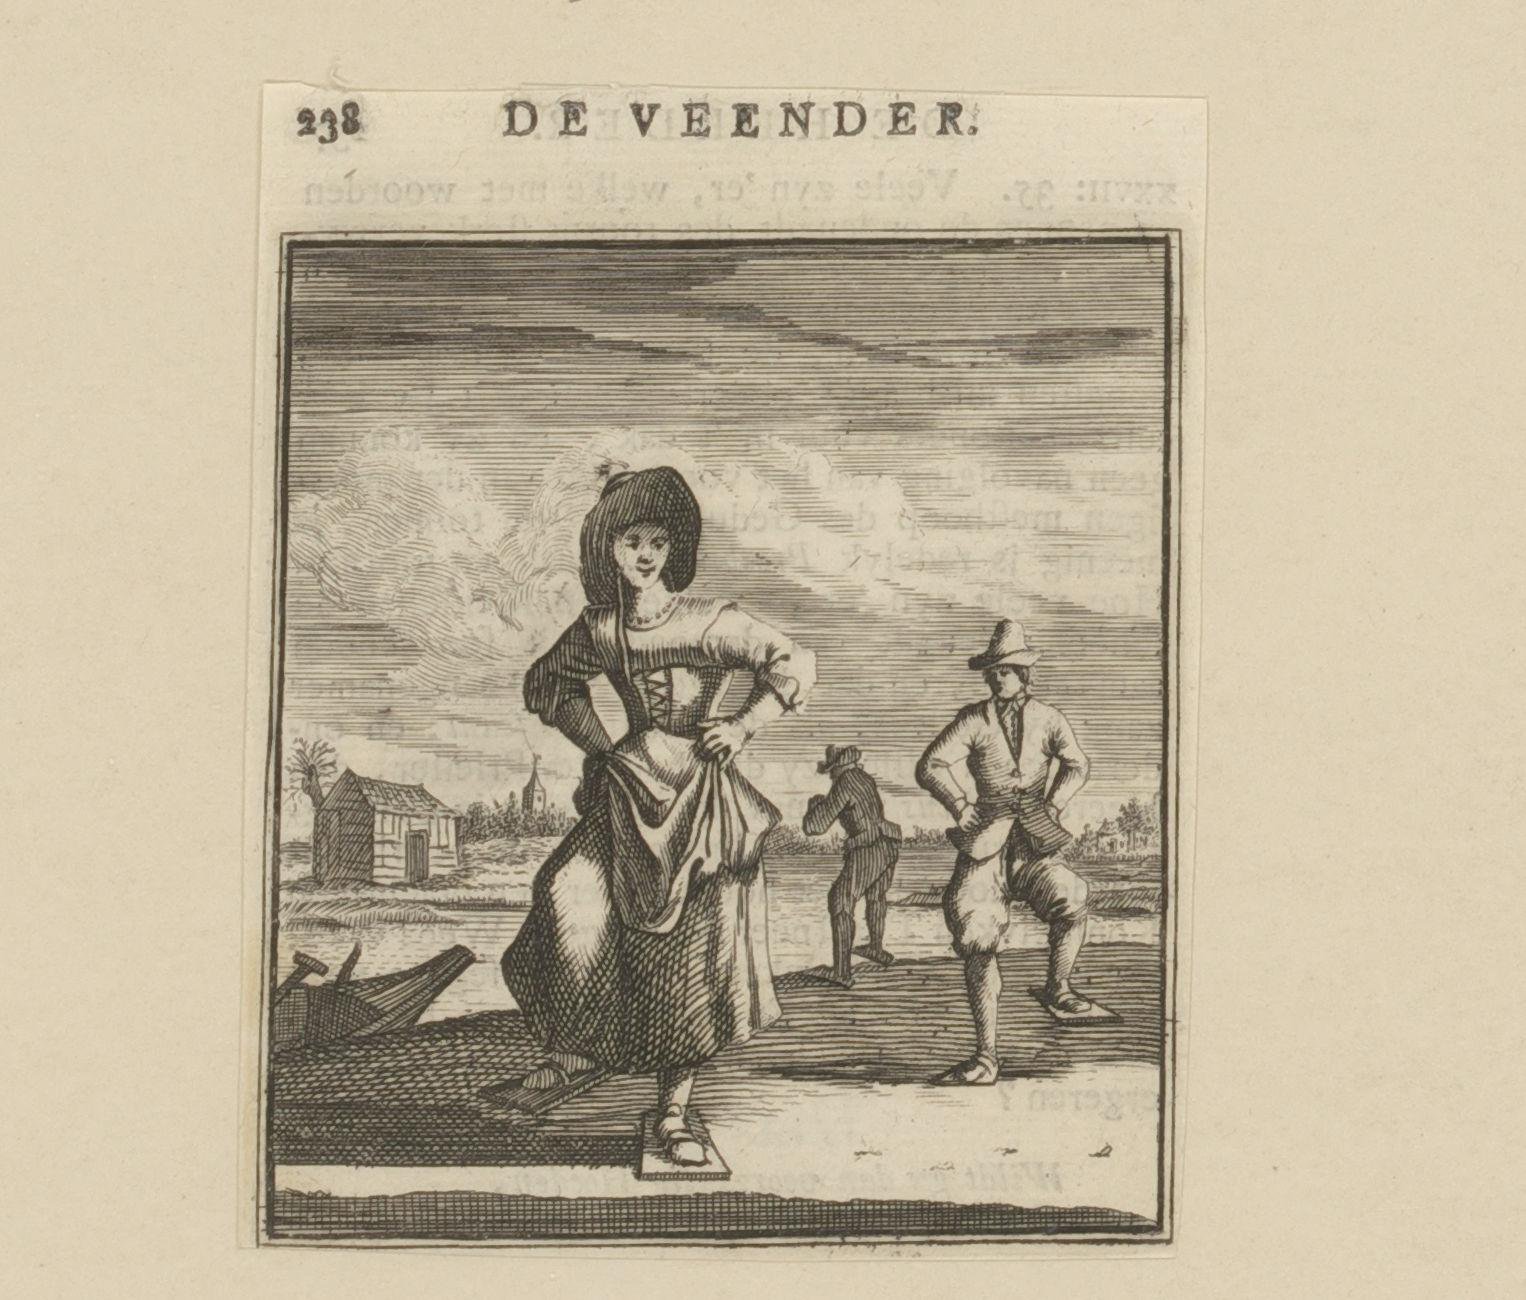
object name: print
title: De Veender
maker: Anonymous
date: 1719-1759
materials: paper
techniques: etching, letterpress printing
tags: peat (soil type), peat-cutting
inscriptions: collector's mark: Lugt 1641, stamp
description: Prent met andere letterzetting gebruikt in: St. Clara, Abraham van. Iets voor allen. [Vertaald door] J. le Long. Amsterdam: Janssoons van Waesberge, 1719, dl. 2. En in: St. Clara, Abraham van. Iets voor allen. [Vertaald door] J. le Long. Amsterdam: Jan Roman de Jonge, 1741, dl. 2. En in: St. Clara, Abraham van. Iets voor allen. [Vertaald door] J. le Long. Amsterdam: Jan Roman, 1759, dl. 2. Huidige prent uit een andere editie. Naar een prent van: Jan Luyken.